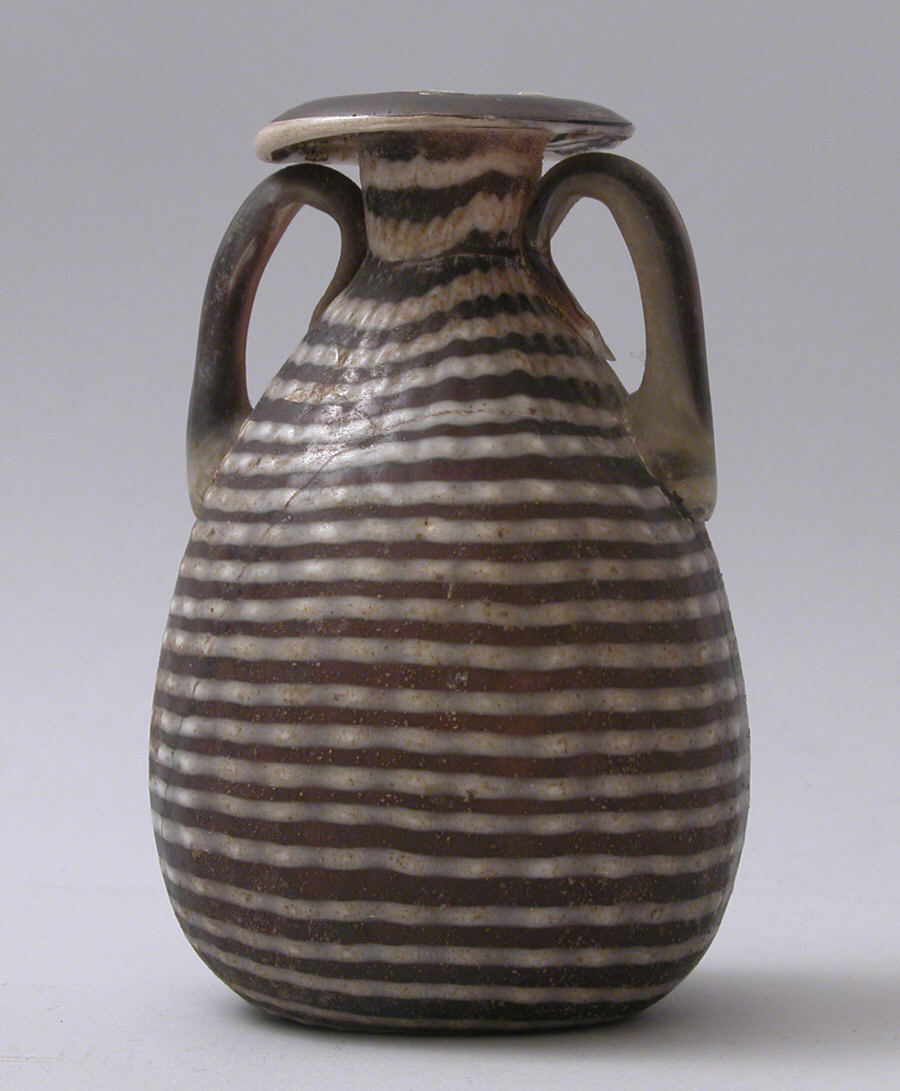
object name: vase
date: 1801-1900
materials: glass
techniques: glassblowing, tooling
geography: italy